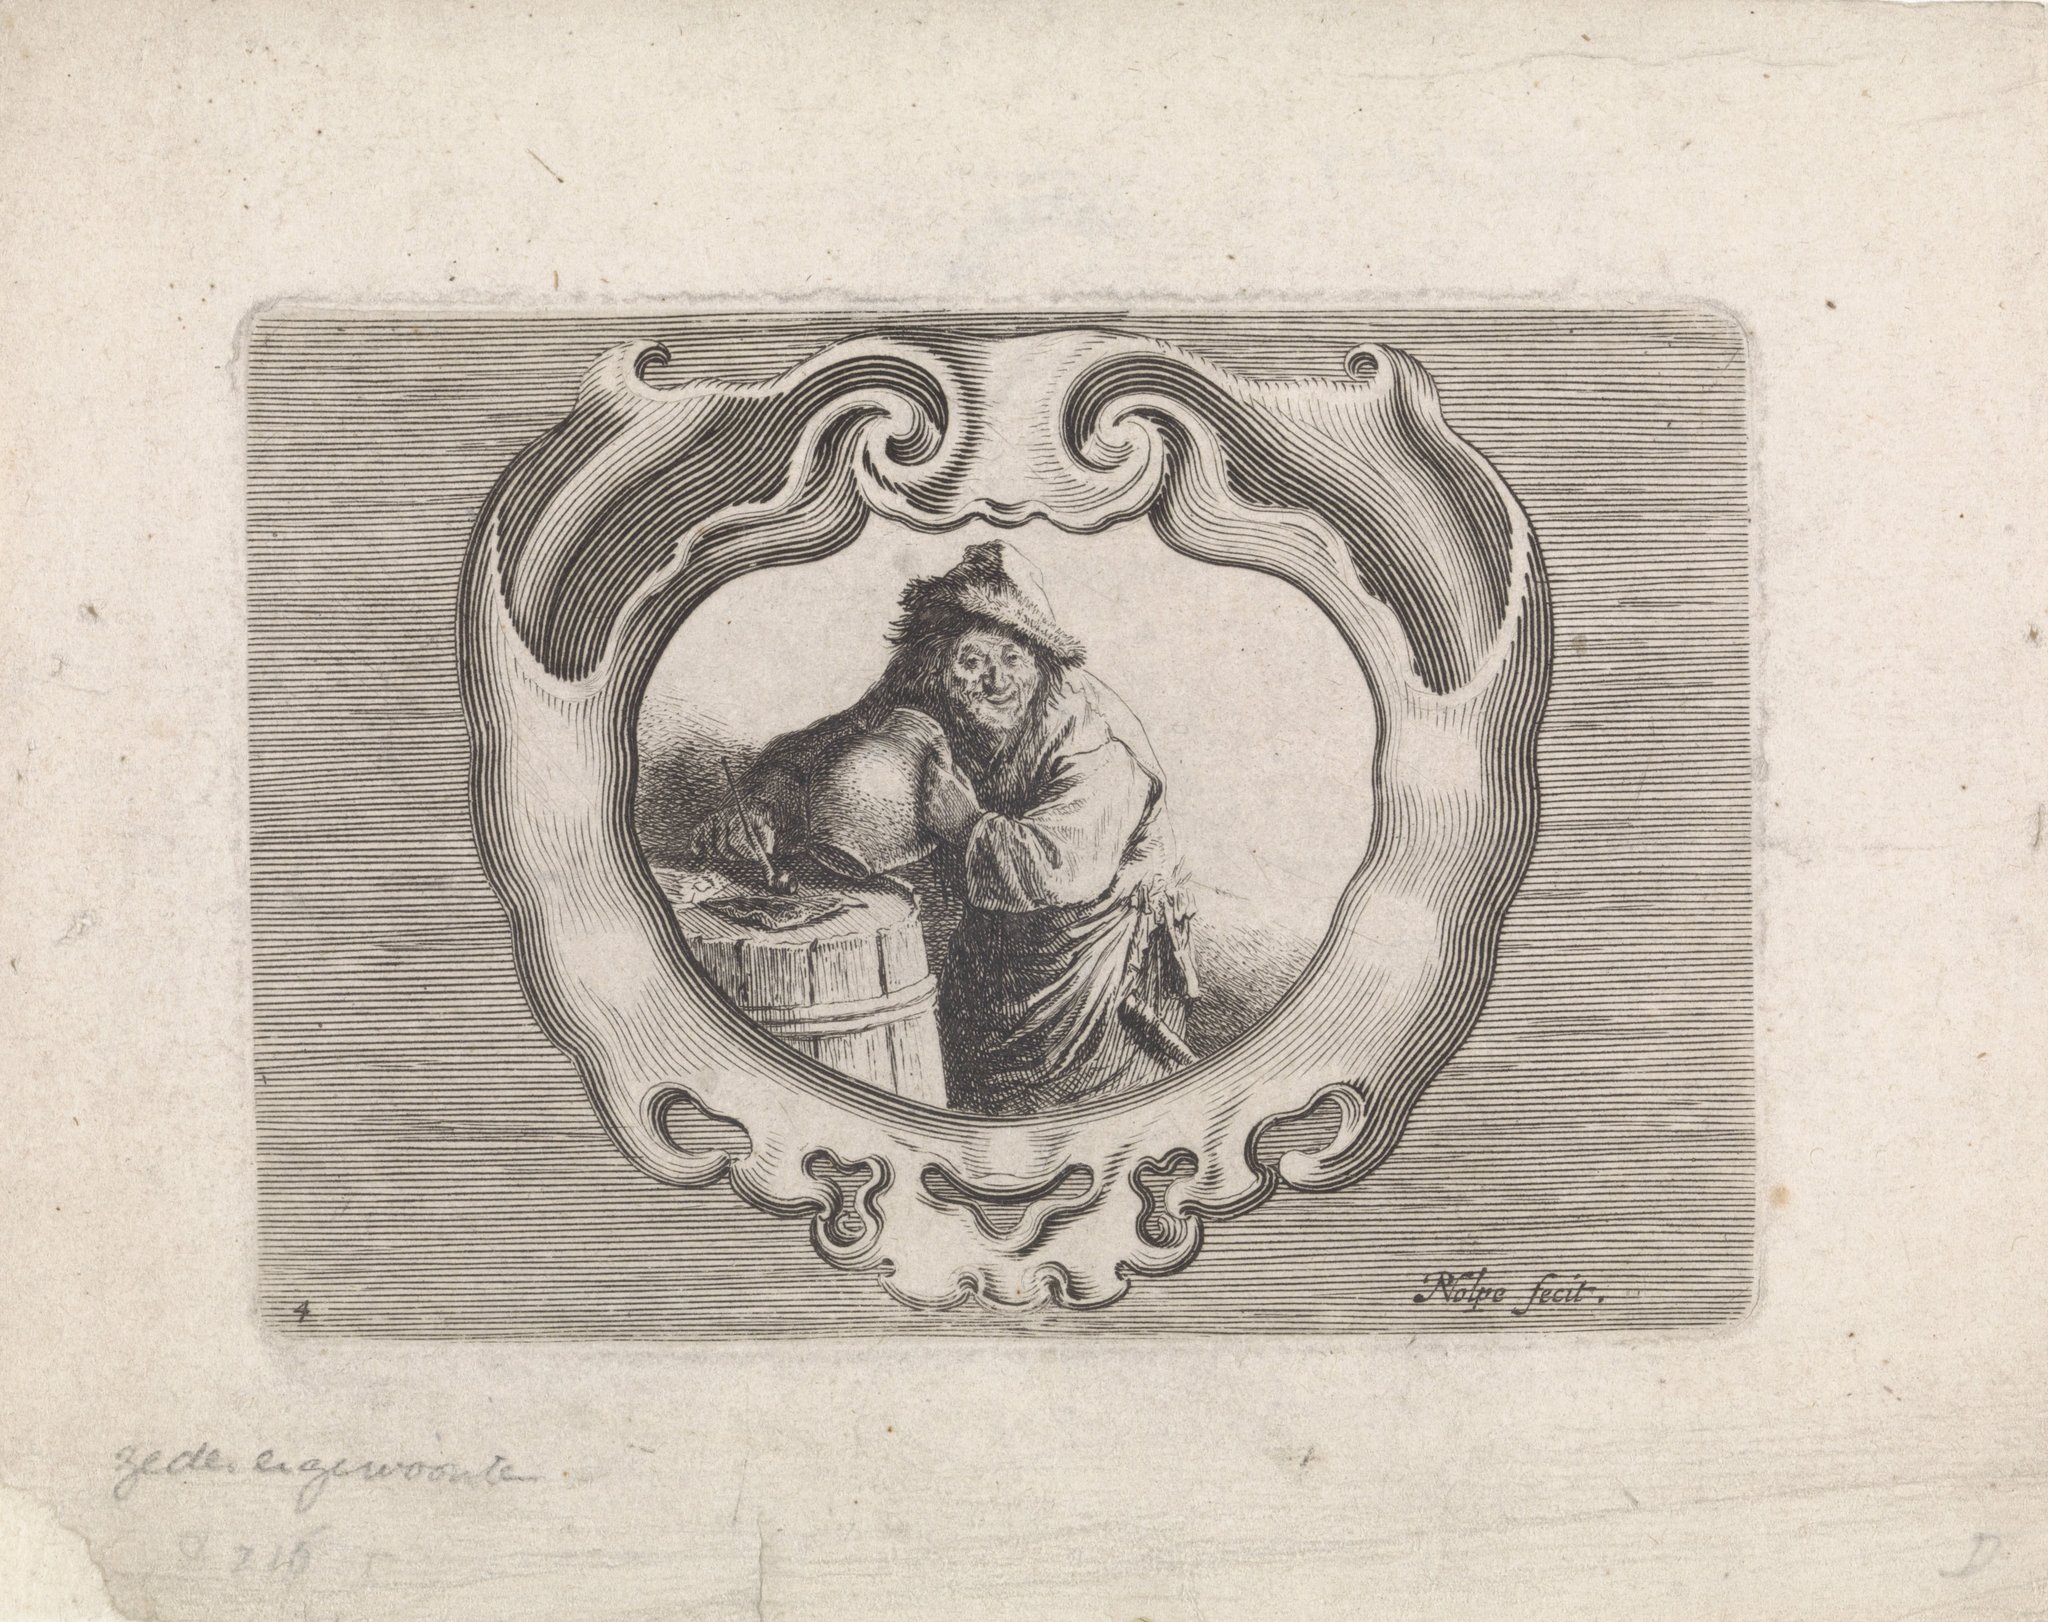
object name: print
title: Boer met kruik en pijp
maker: pieter nolpe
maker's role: draughtsman, print maker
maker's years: 1613-1653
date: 1623-1653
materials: paper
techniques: engraving, etching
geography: amsterdam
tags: wooden container: barrel, cask, bucket, pipe ~ tobacco, jar, jug (used as drinking-vessel), farmers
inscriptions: collector's mark: Lugt 2228, collector's mark: Lugt 2233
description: Een oude boer staat bij een houten ton met een kruik in de ene en een pijp in de andere hand. de voorstelling is gevat in een ornamentele lijst. Prent maakt deel uit van een serie met scènes uit het boerenleven.